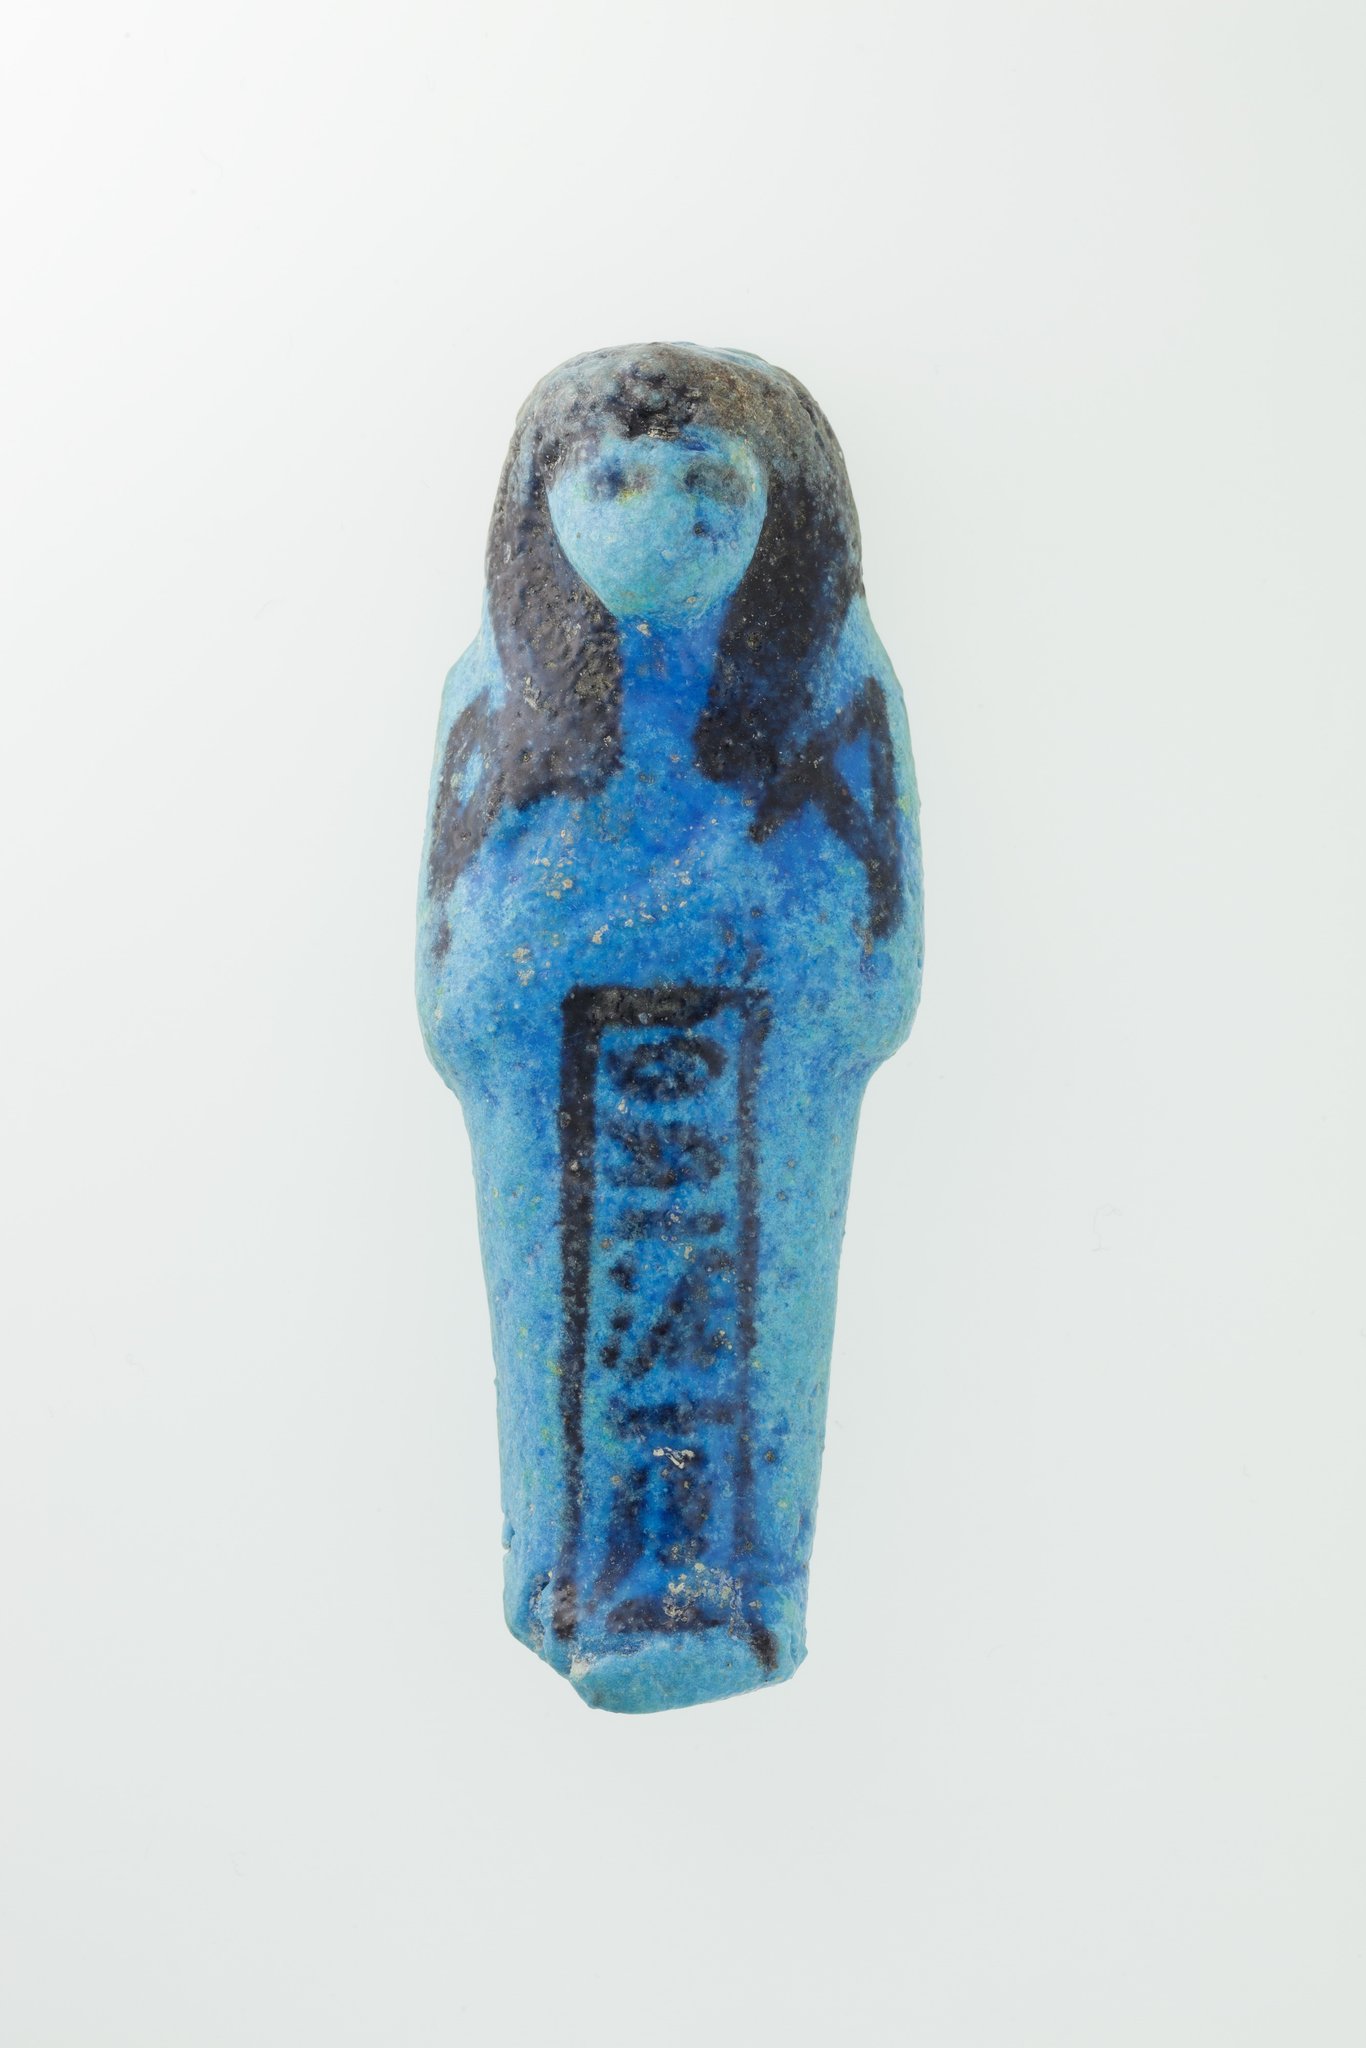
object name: shabti, worker, nauny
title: Worker Shabti of Nauny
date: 1050 BCE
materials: faience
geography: egypt